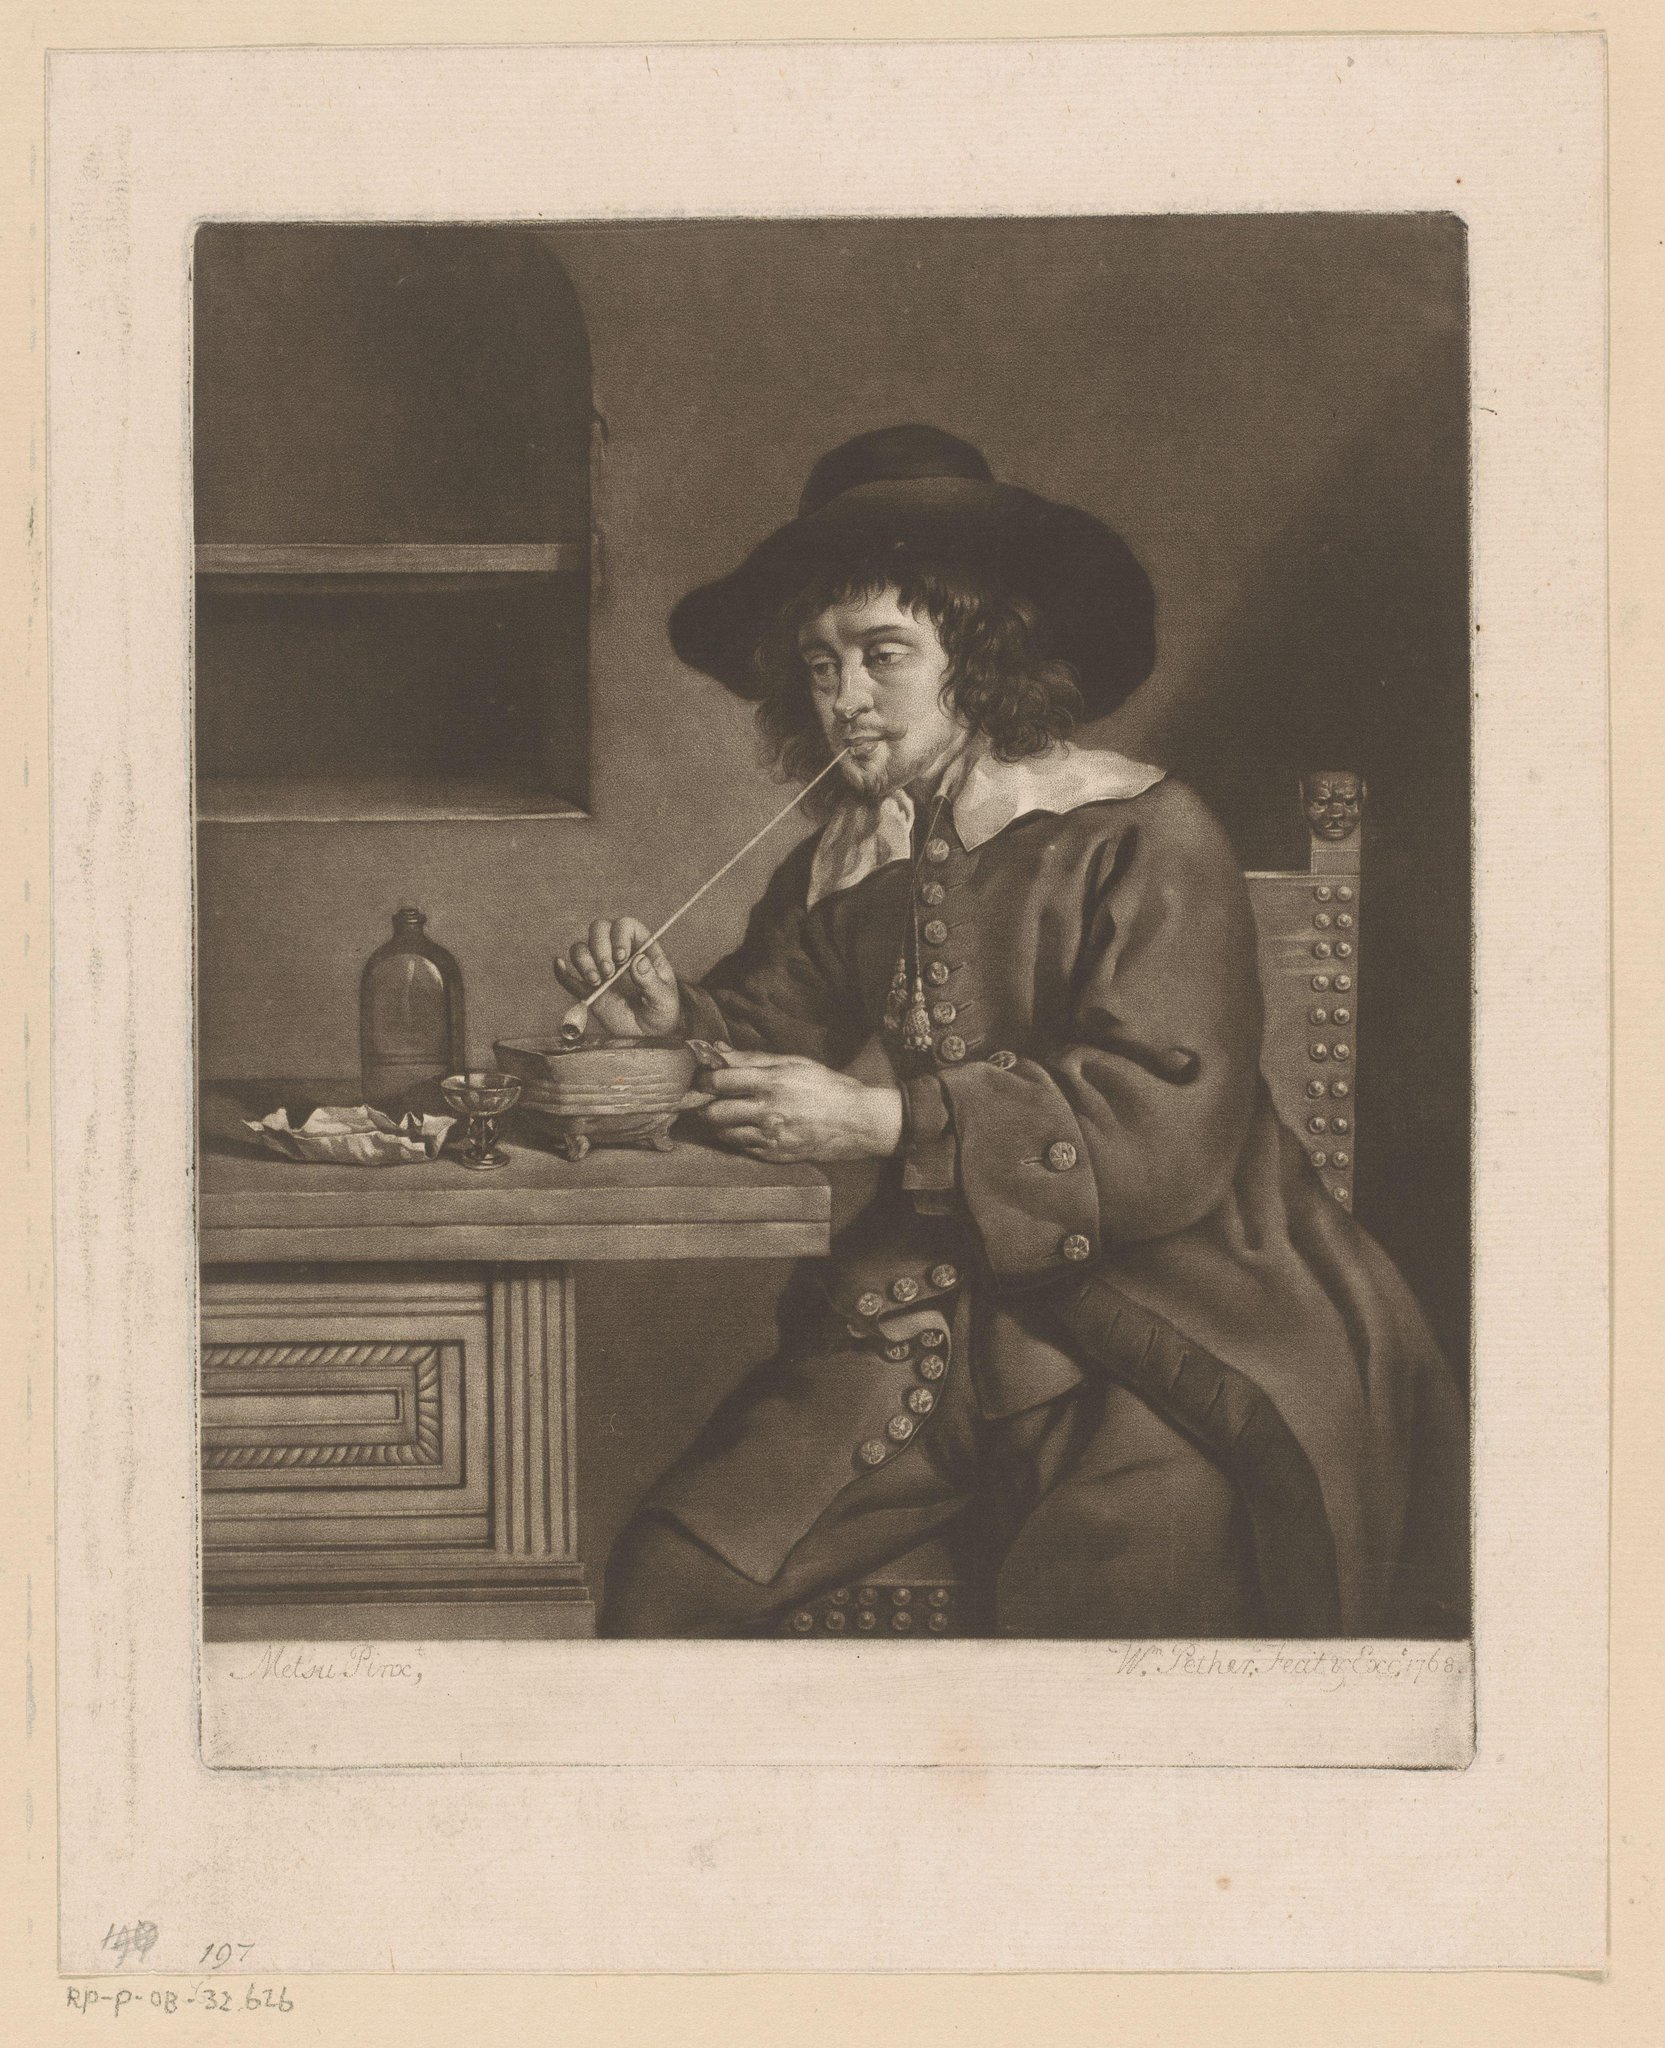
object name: print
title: Pijprokende man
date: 1768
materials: paper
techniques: mezzotint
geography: london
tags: adult man, pipe ~ tobacco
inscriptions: collector's mark: Lugt 240